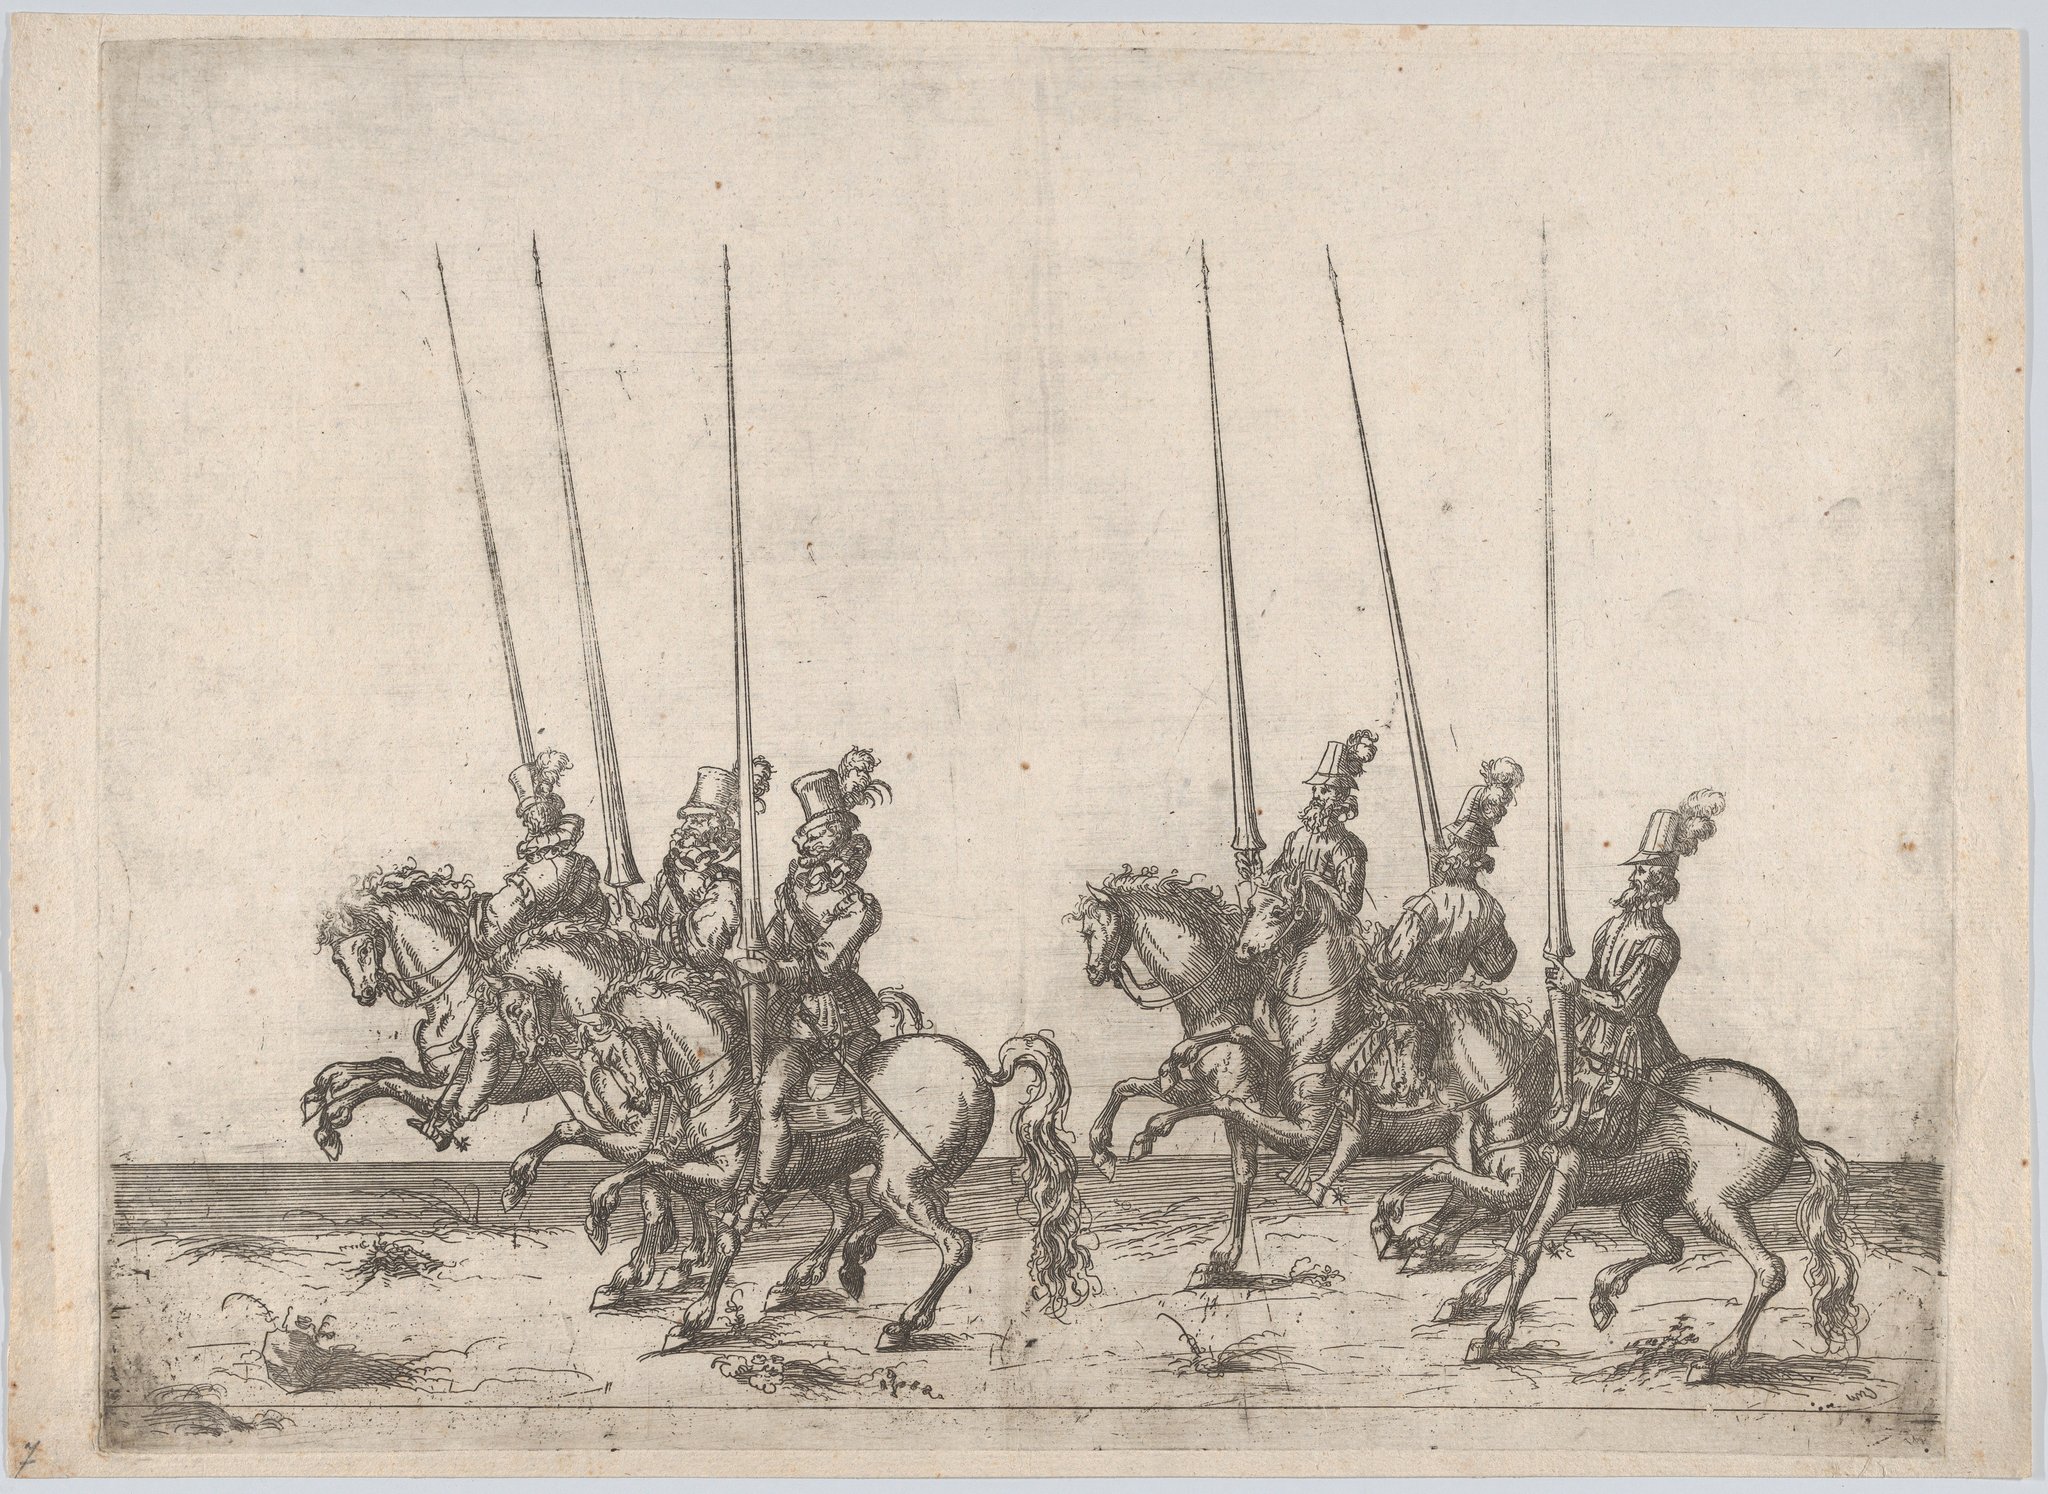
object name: print, fete, ornament architecture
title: Procession, with six men riding horses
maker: anonymous, german, 16th century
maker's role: artist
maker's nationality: german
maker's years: 1500-1600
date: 1501-1600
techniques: etching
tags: weapons,men,horses